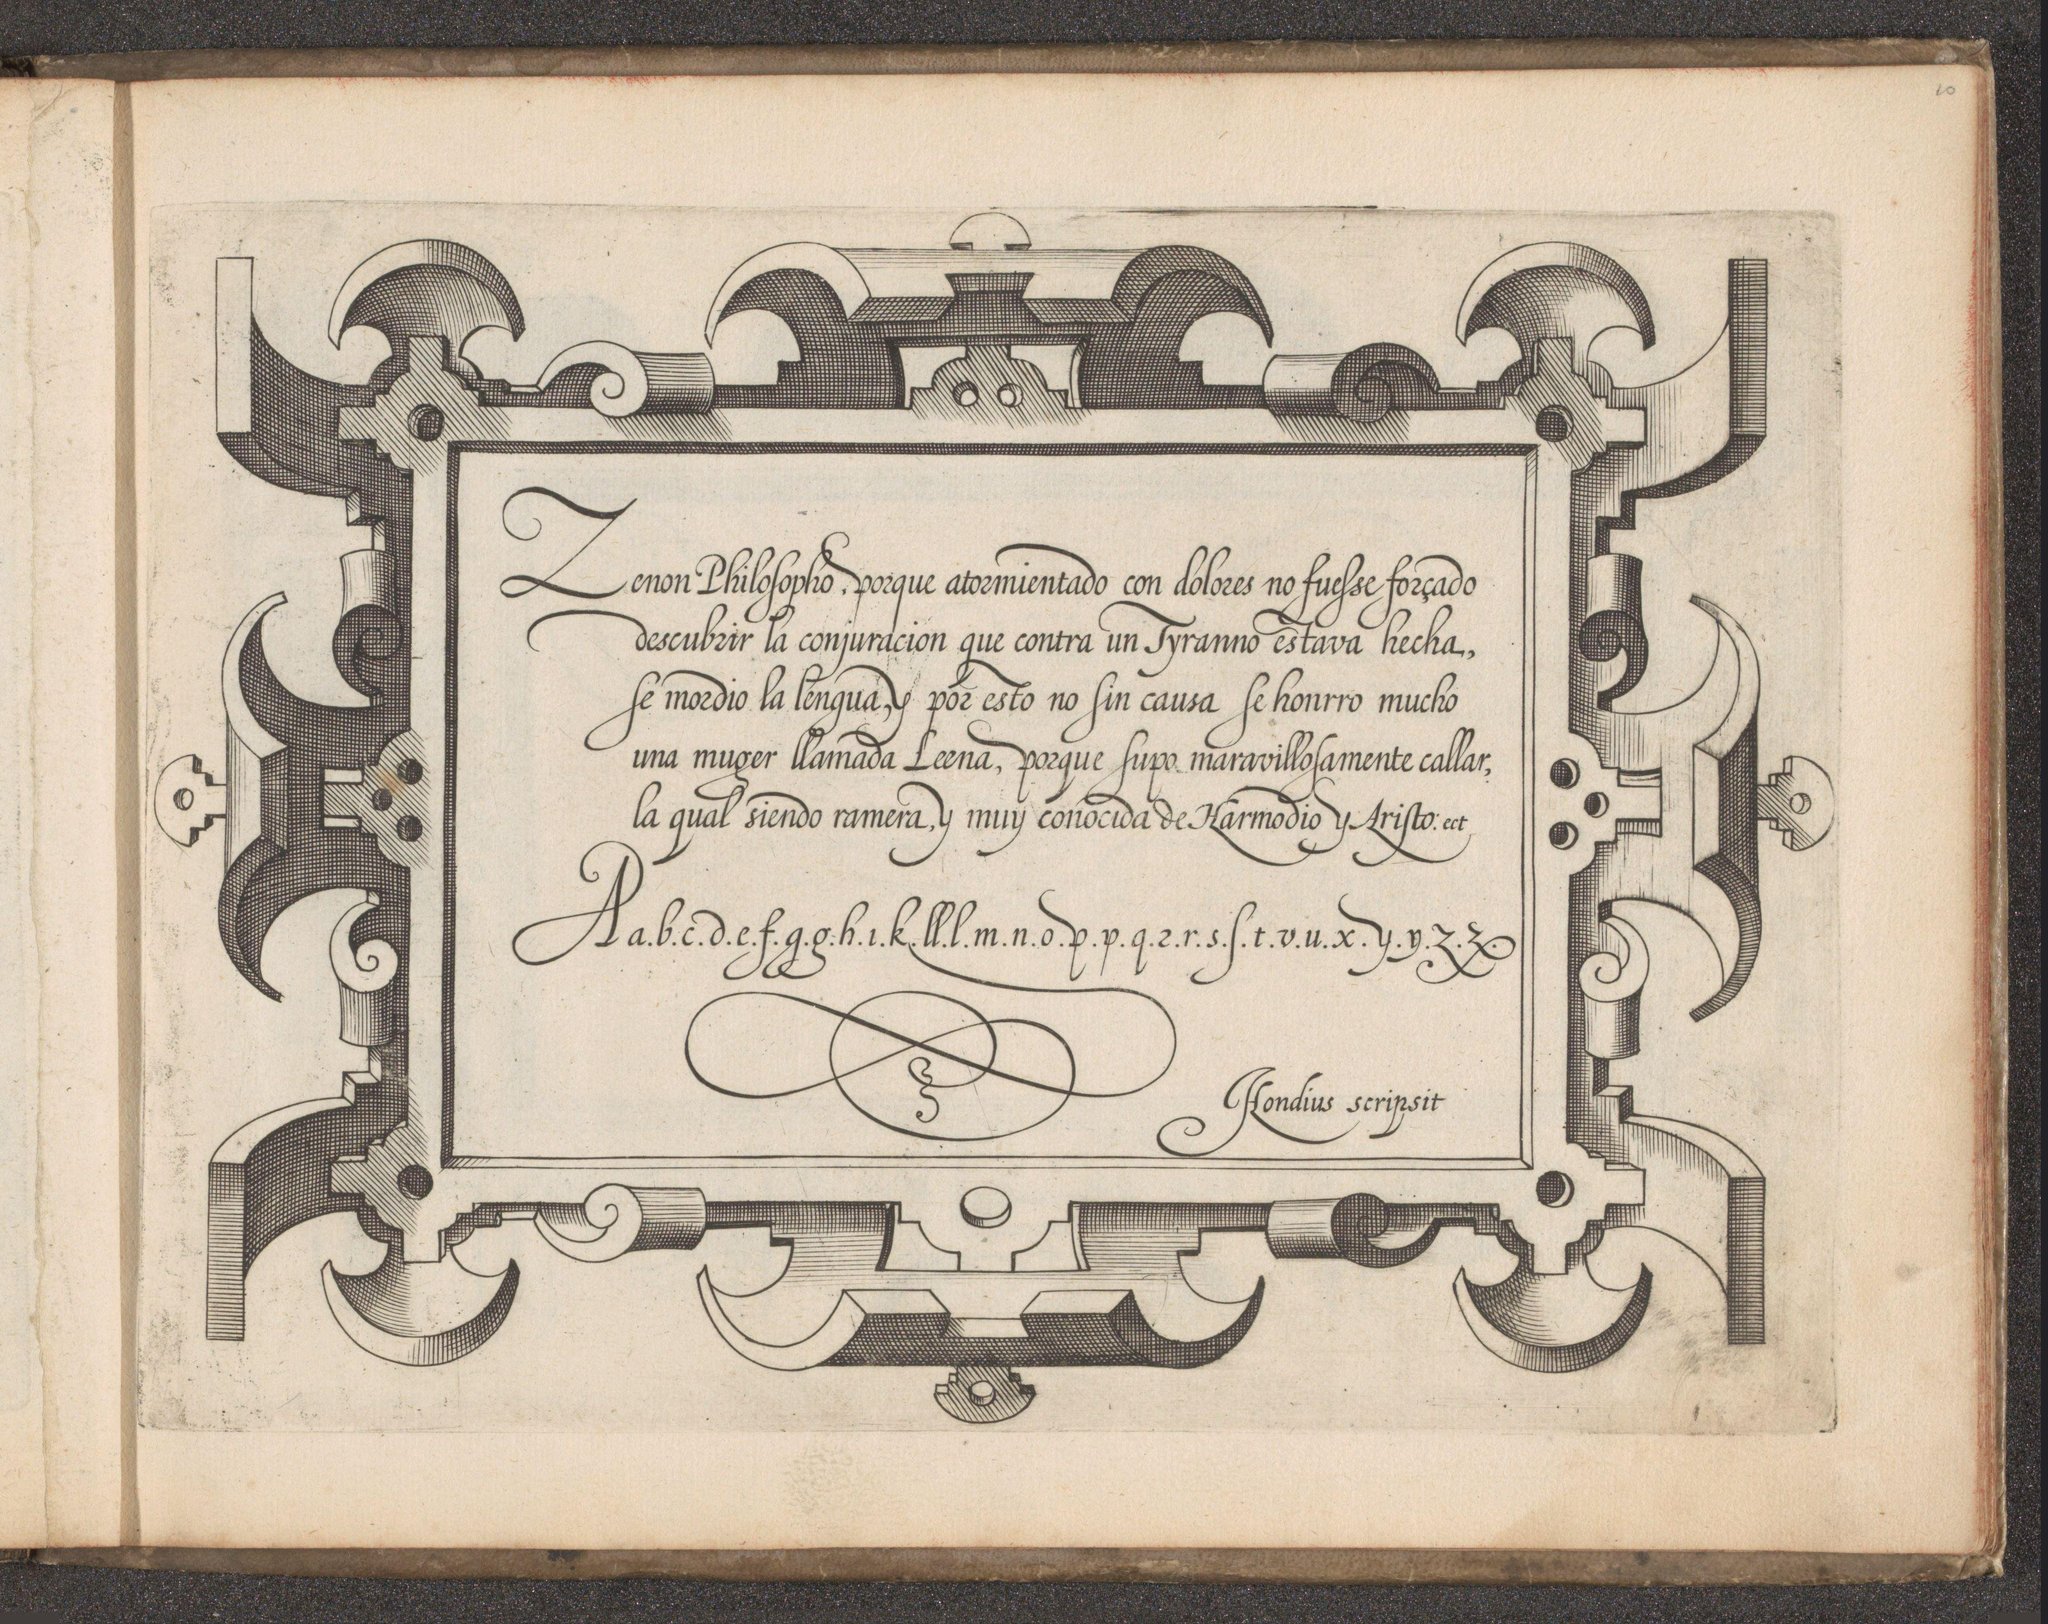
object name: album leaf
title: Litera Anglicana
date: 1614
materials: paper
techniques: engraving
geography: amsterdam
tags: scrollwork, strapwork ~ ornament, ornament ~ cartouche, calligraphy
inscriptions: signature and date: ‘Op titelblad: Judoco Hondio celatore. Amstelodami apud Joannem Janssonium. 1614’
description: Schrijfvoorbeeld in een gotische hand met een titel in het Latijn en vier regels tekst in het Engels. Het voorbeeld is gevat in een rolwerkcartouche. De prent maakt deel uit van een album.